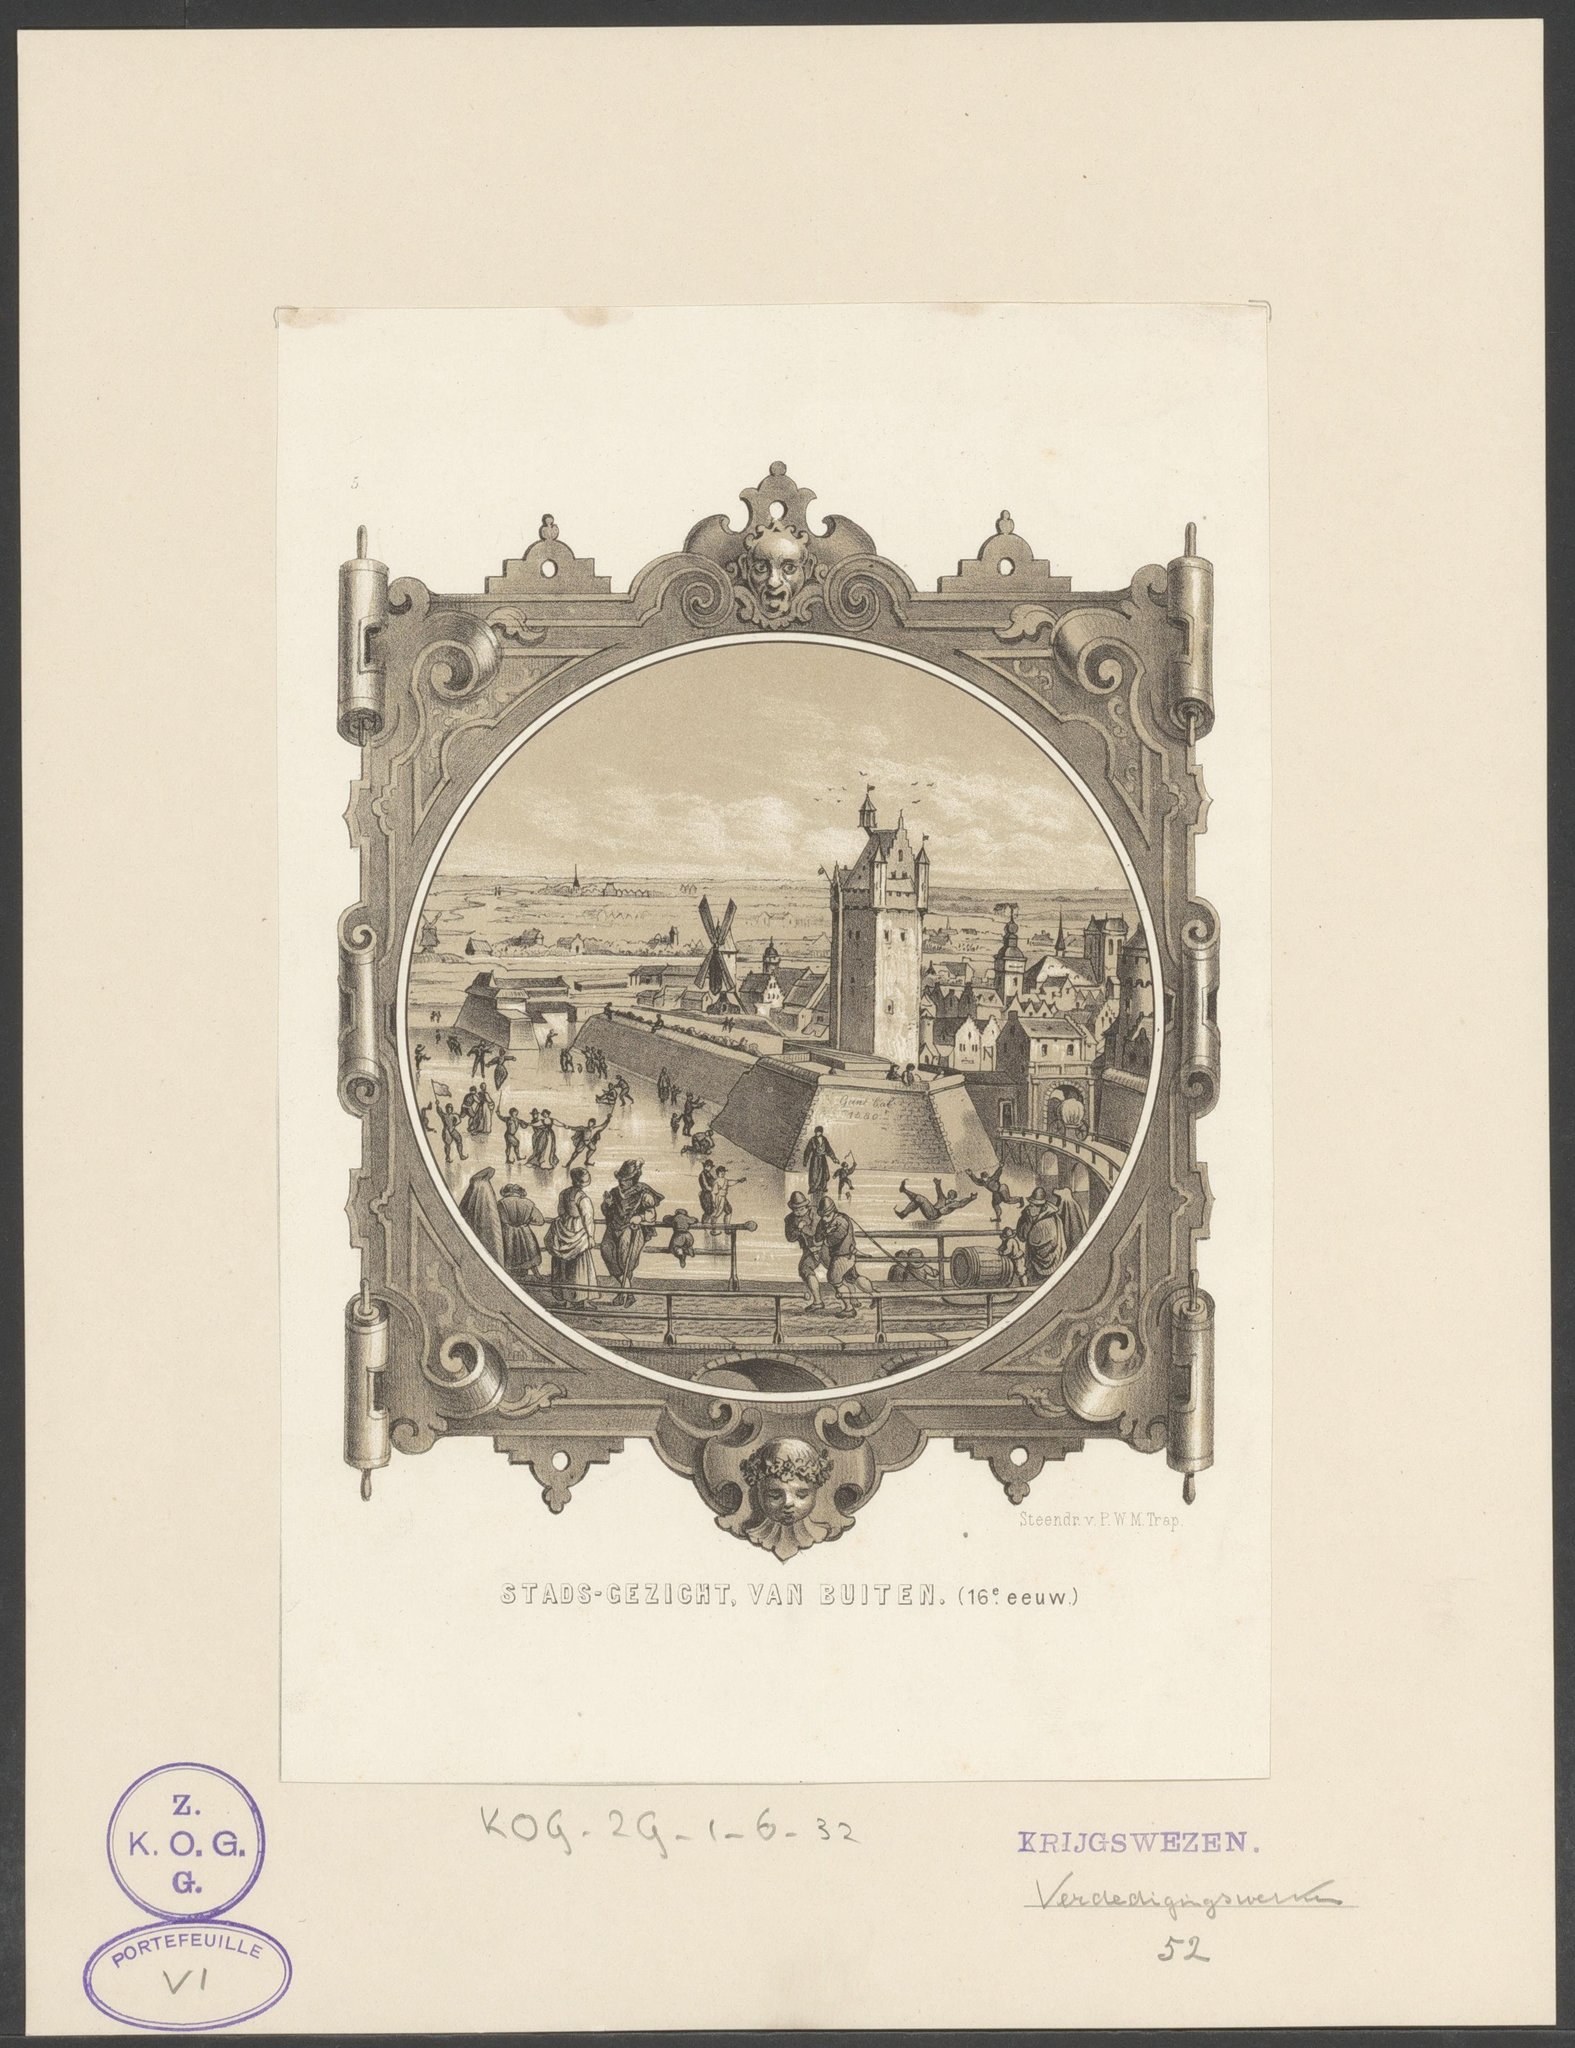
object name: print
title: Gezicht op een stad met schaatsende mensen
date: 1873-1875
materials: paper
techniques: tone lithography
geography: leiden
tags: winter landscape; landscape symbolizing winter (the four seasons of the year), skates (winter sports), frame of painting, etc.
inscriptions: stamp, collector's mark: Lugt 1641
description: Prent waarschijnlijk uit: Hofdijk, W.J. Ons voorgeslacht in zijn dagelyksch leven geschilderd. Tweede druk. Leiden: P. van Santen, ca. 1875.